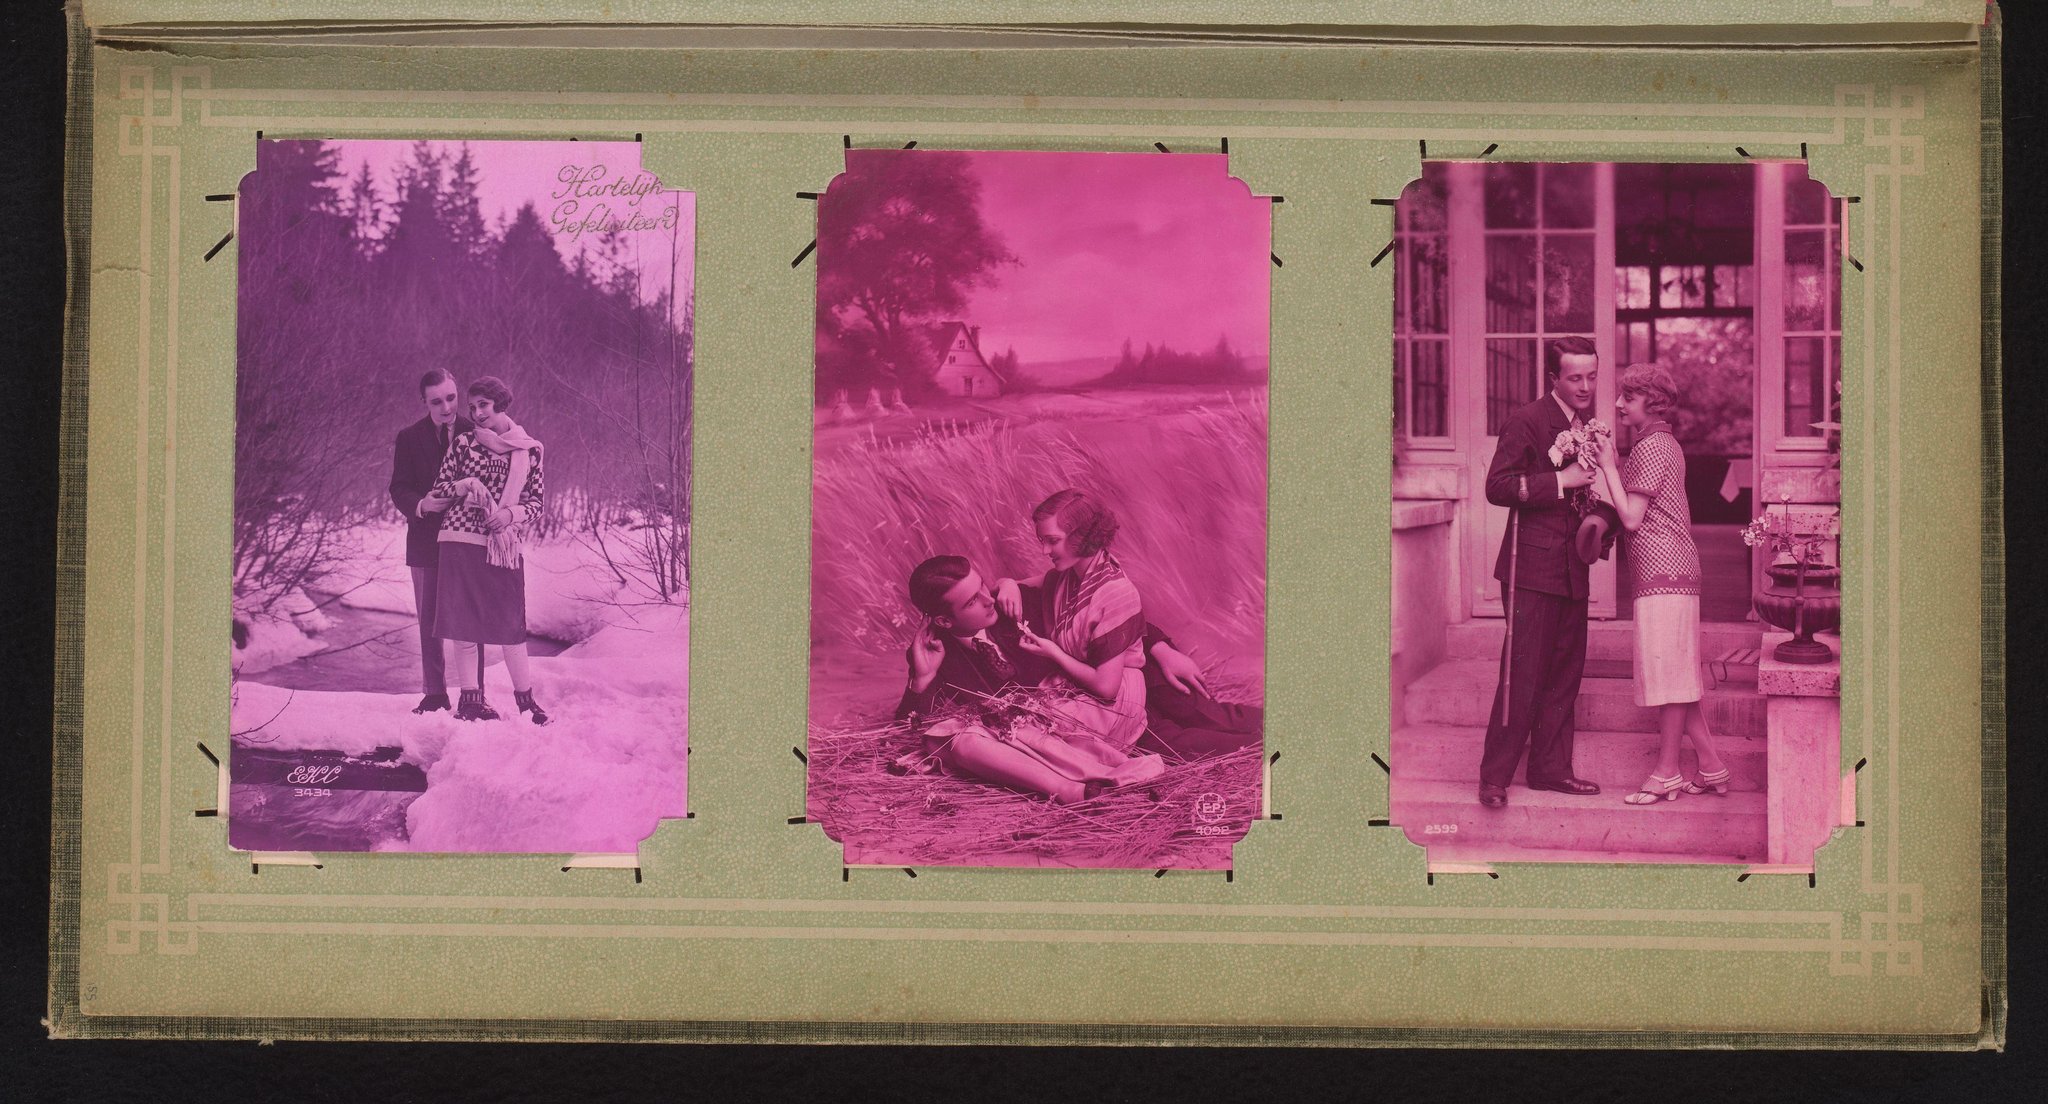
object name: album leaf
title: Drie portretten van een paar geliefden, in de sneeuw, in een veld en voor een gebouw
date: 1900-1930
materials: cardboard, photographic support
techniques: gelatin silver print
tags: meadow, pasture, snow, couple of lovers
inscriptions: monogram: ‘EP’, monogram: ‘EKC’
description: Deze foto's maken deel uit van een album.